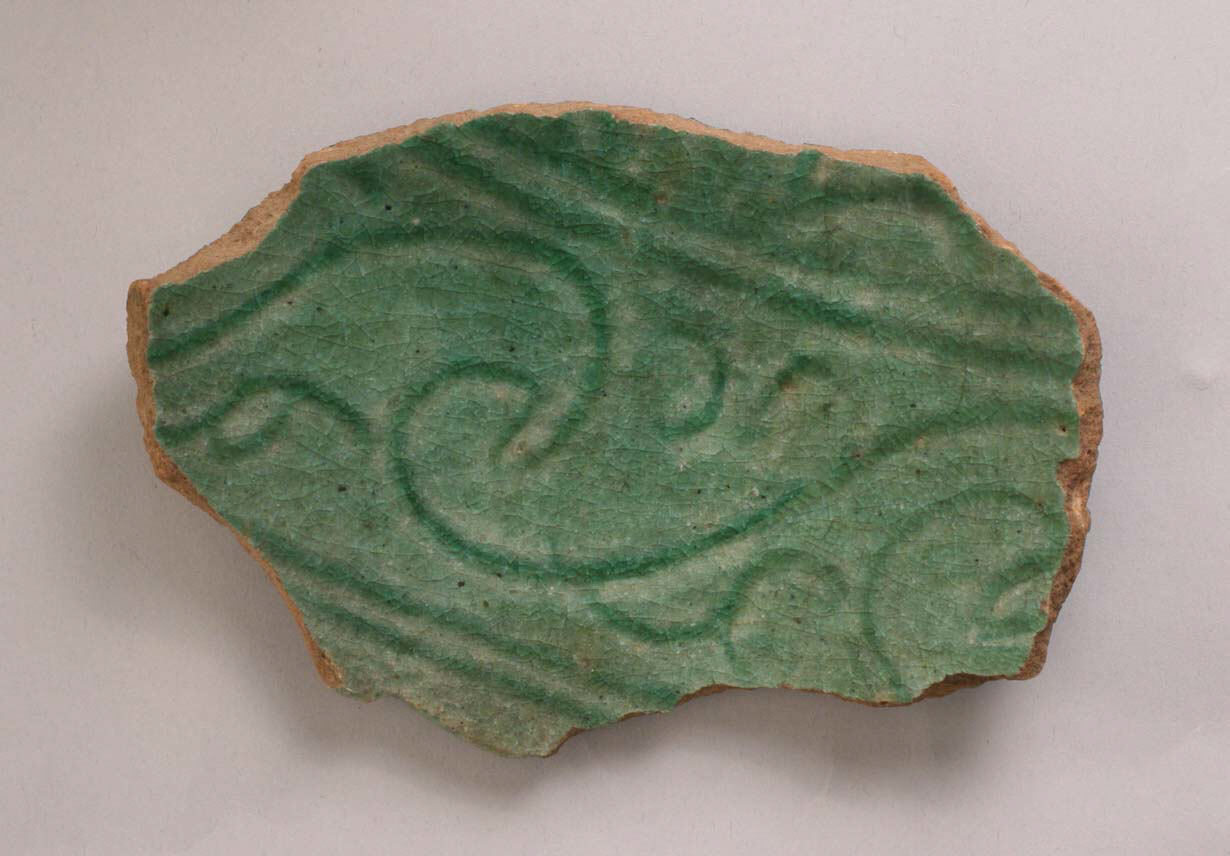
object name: ceramic fragment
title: Dish Fragment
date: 1001-1200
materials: earthenware, glaze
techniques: incising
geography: egypt